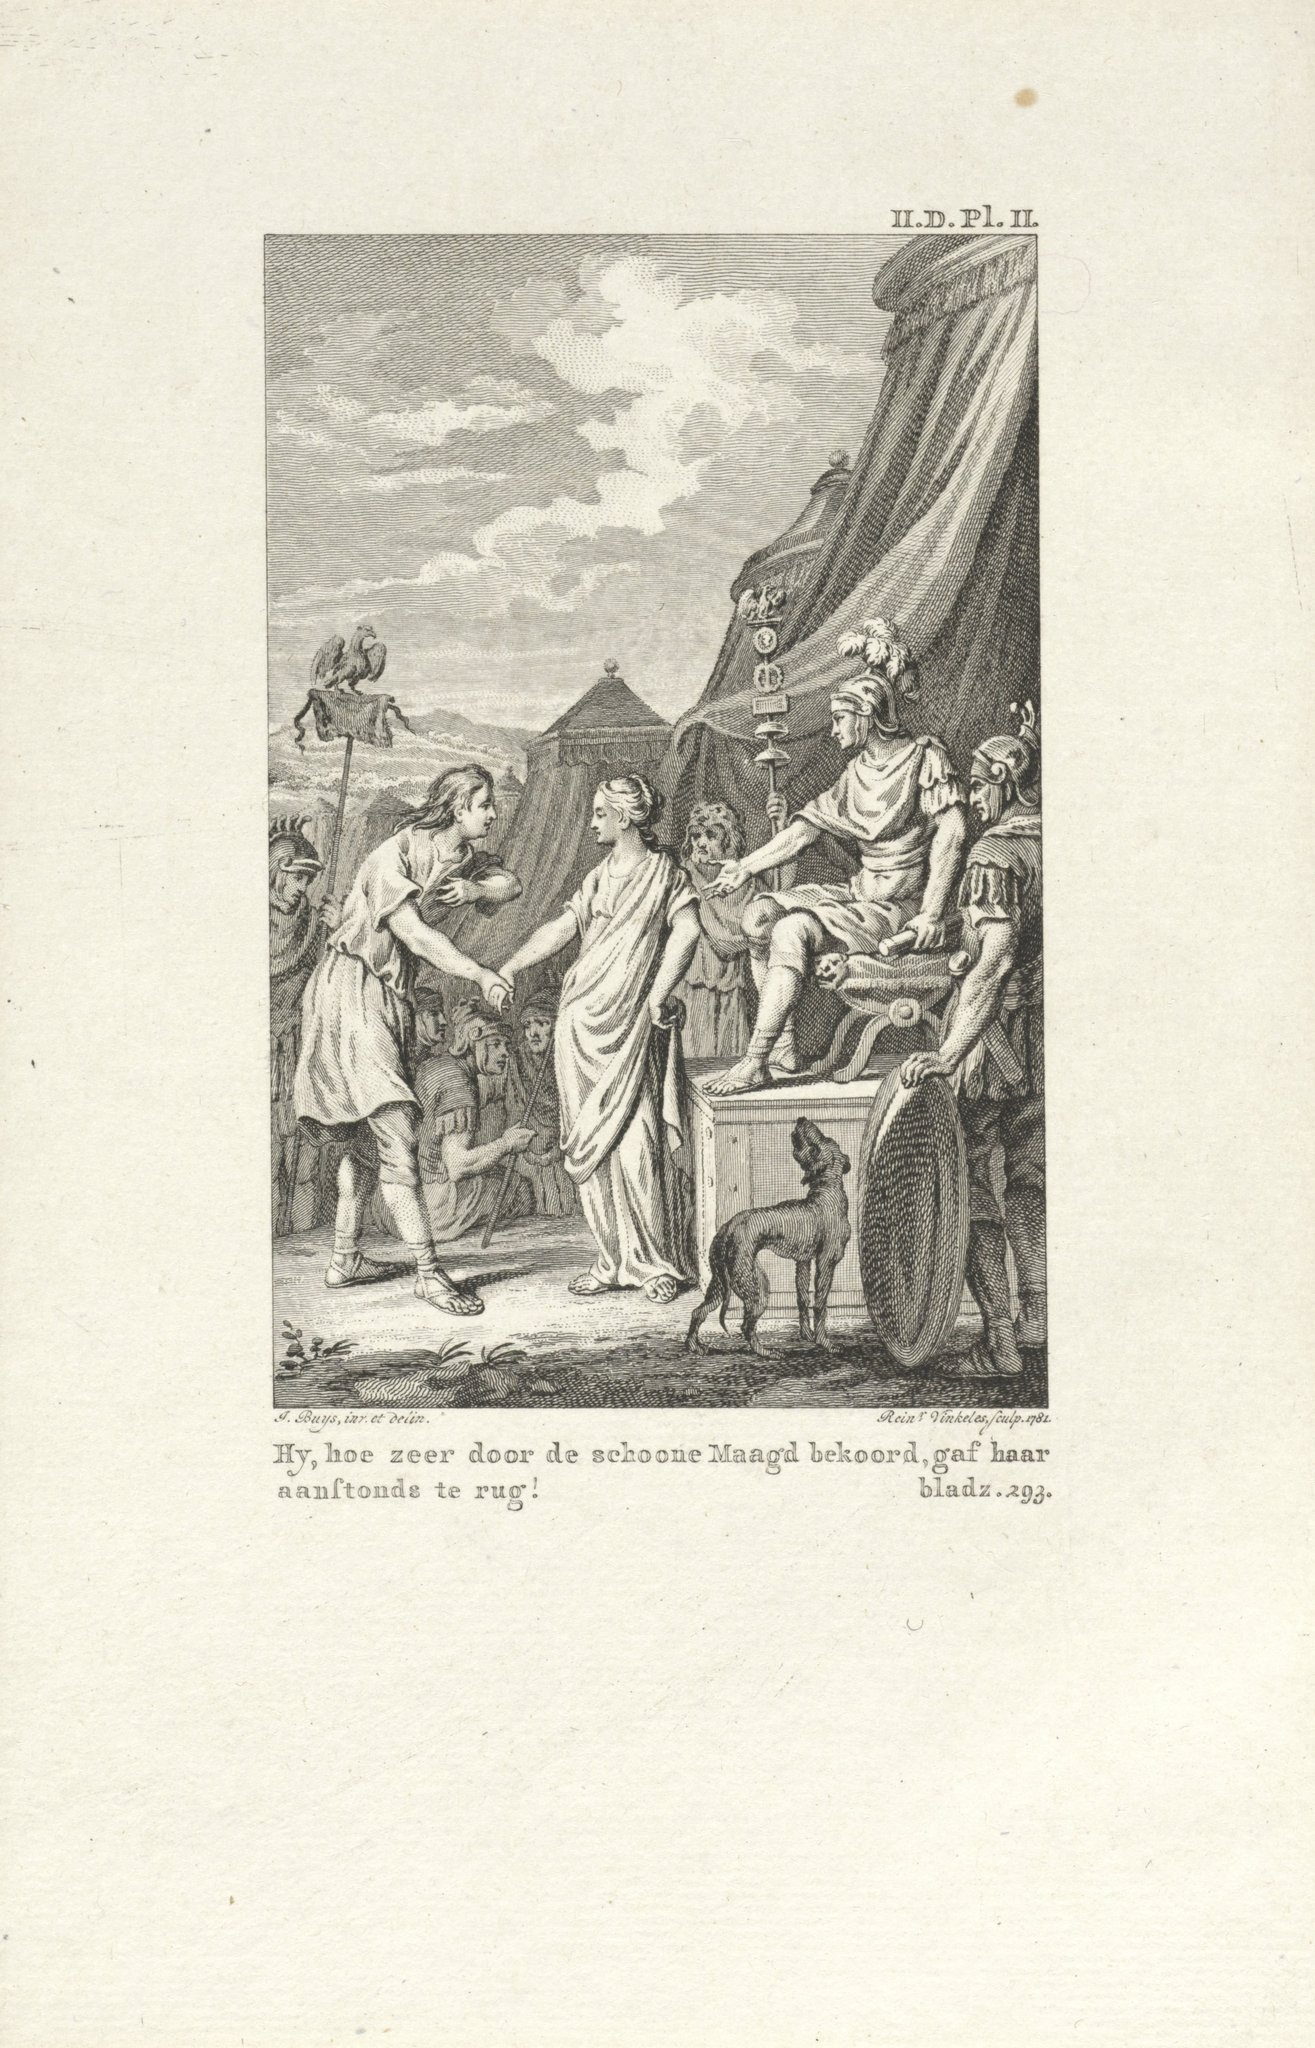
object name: book illustration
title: Scipio en de bruid van Numantia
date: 1781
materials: paper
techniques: engraving, etching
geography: amsterdam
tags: politician, adolescent, young woman, maiden, (military) camp with tents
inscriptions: collector's mark: Lugt 240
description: De Romeinse generaal Publius Cornelius Scipio Africanus maior geeft na de verovering van Carthago een schone krijgsgevangene terug aan haar verloofde. Rechtsboven: II.D.Pl.II. rechtsonder: bladz.293.